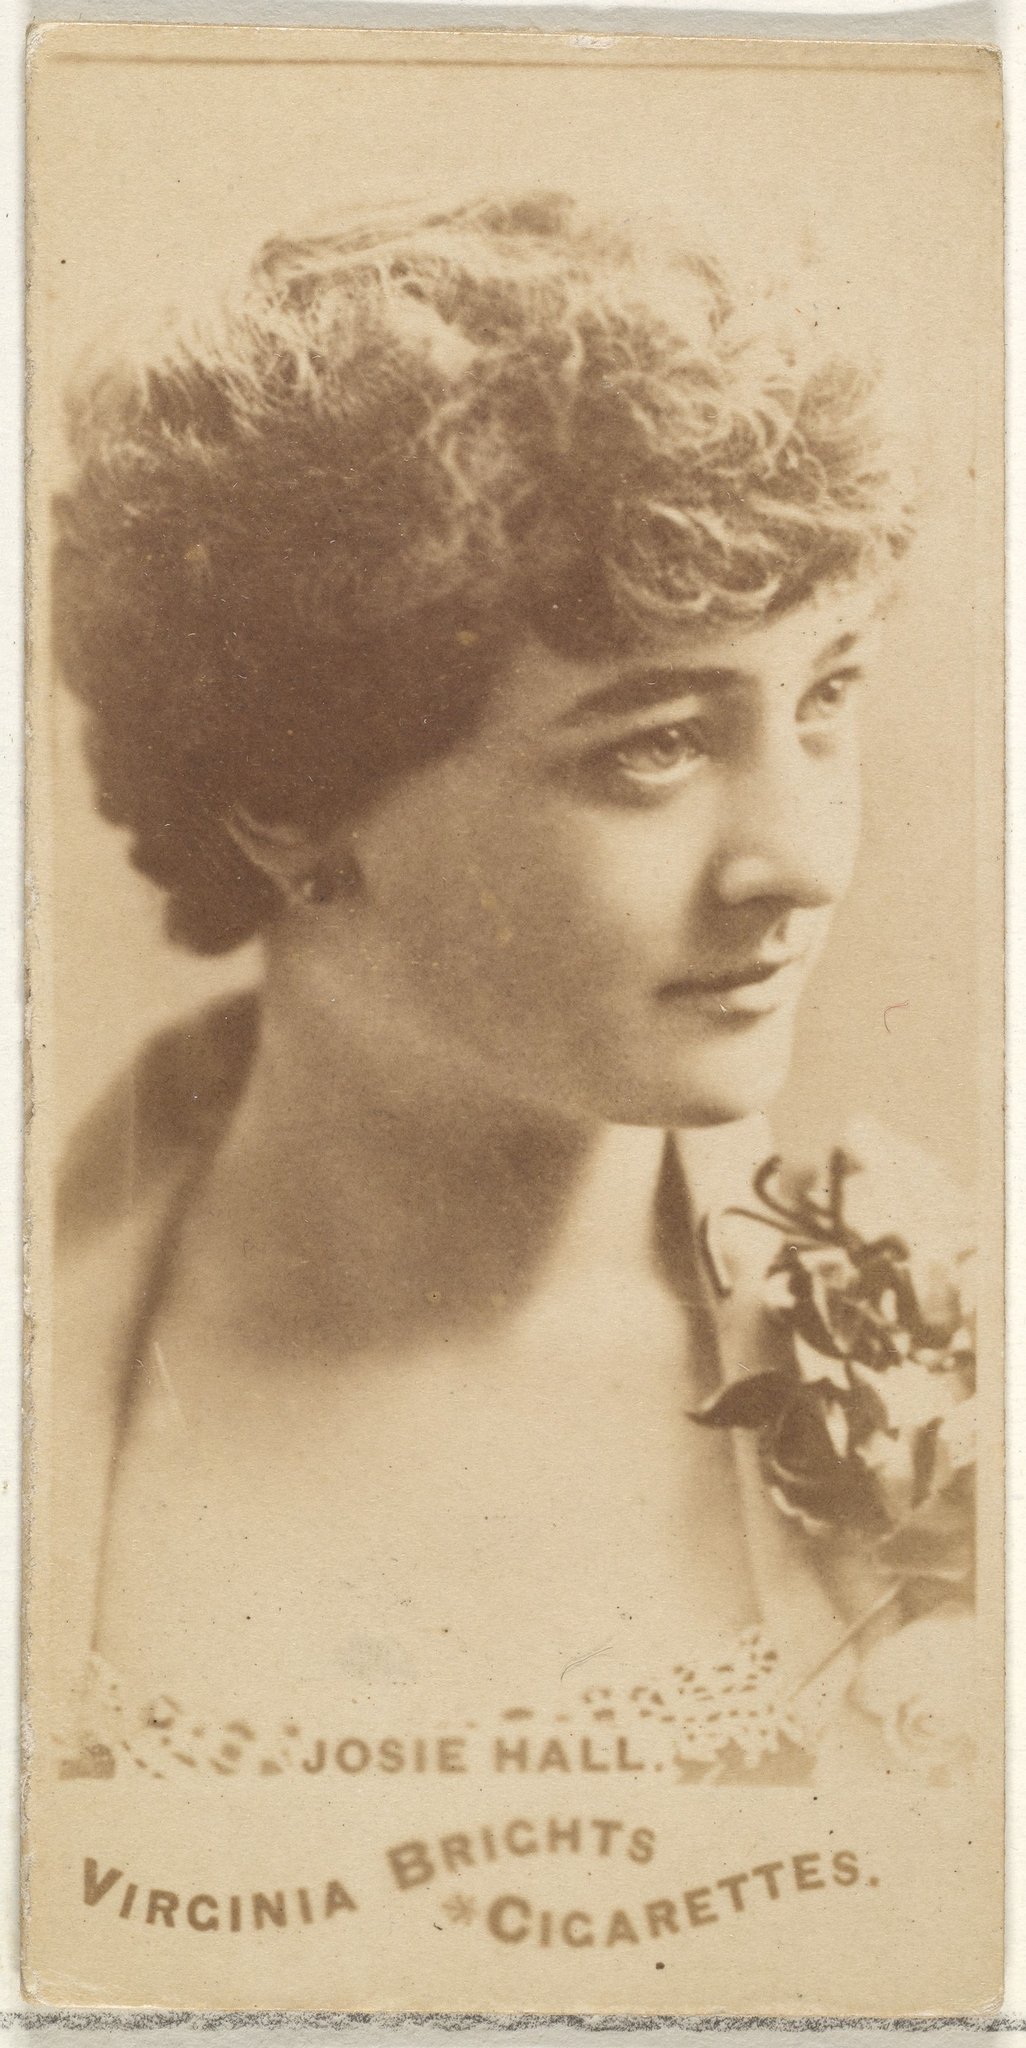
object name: photograph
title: Josie Hall, from the Actors and Actresses series (N45, Type 1) for Virginia Brights Cigarettes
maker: allen & ginter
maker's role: publisher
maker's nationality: american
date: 1888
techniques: albumen silver print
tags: portraits,women,actresses